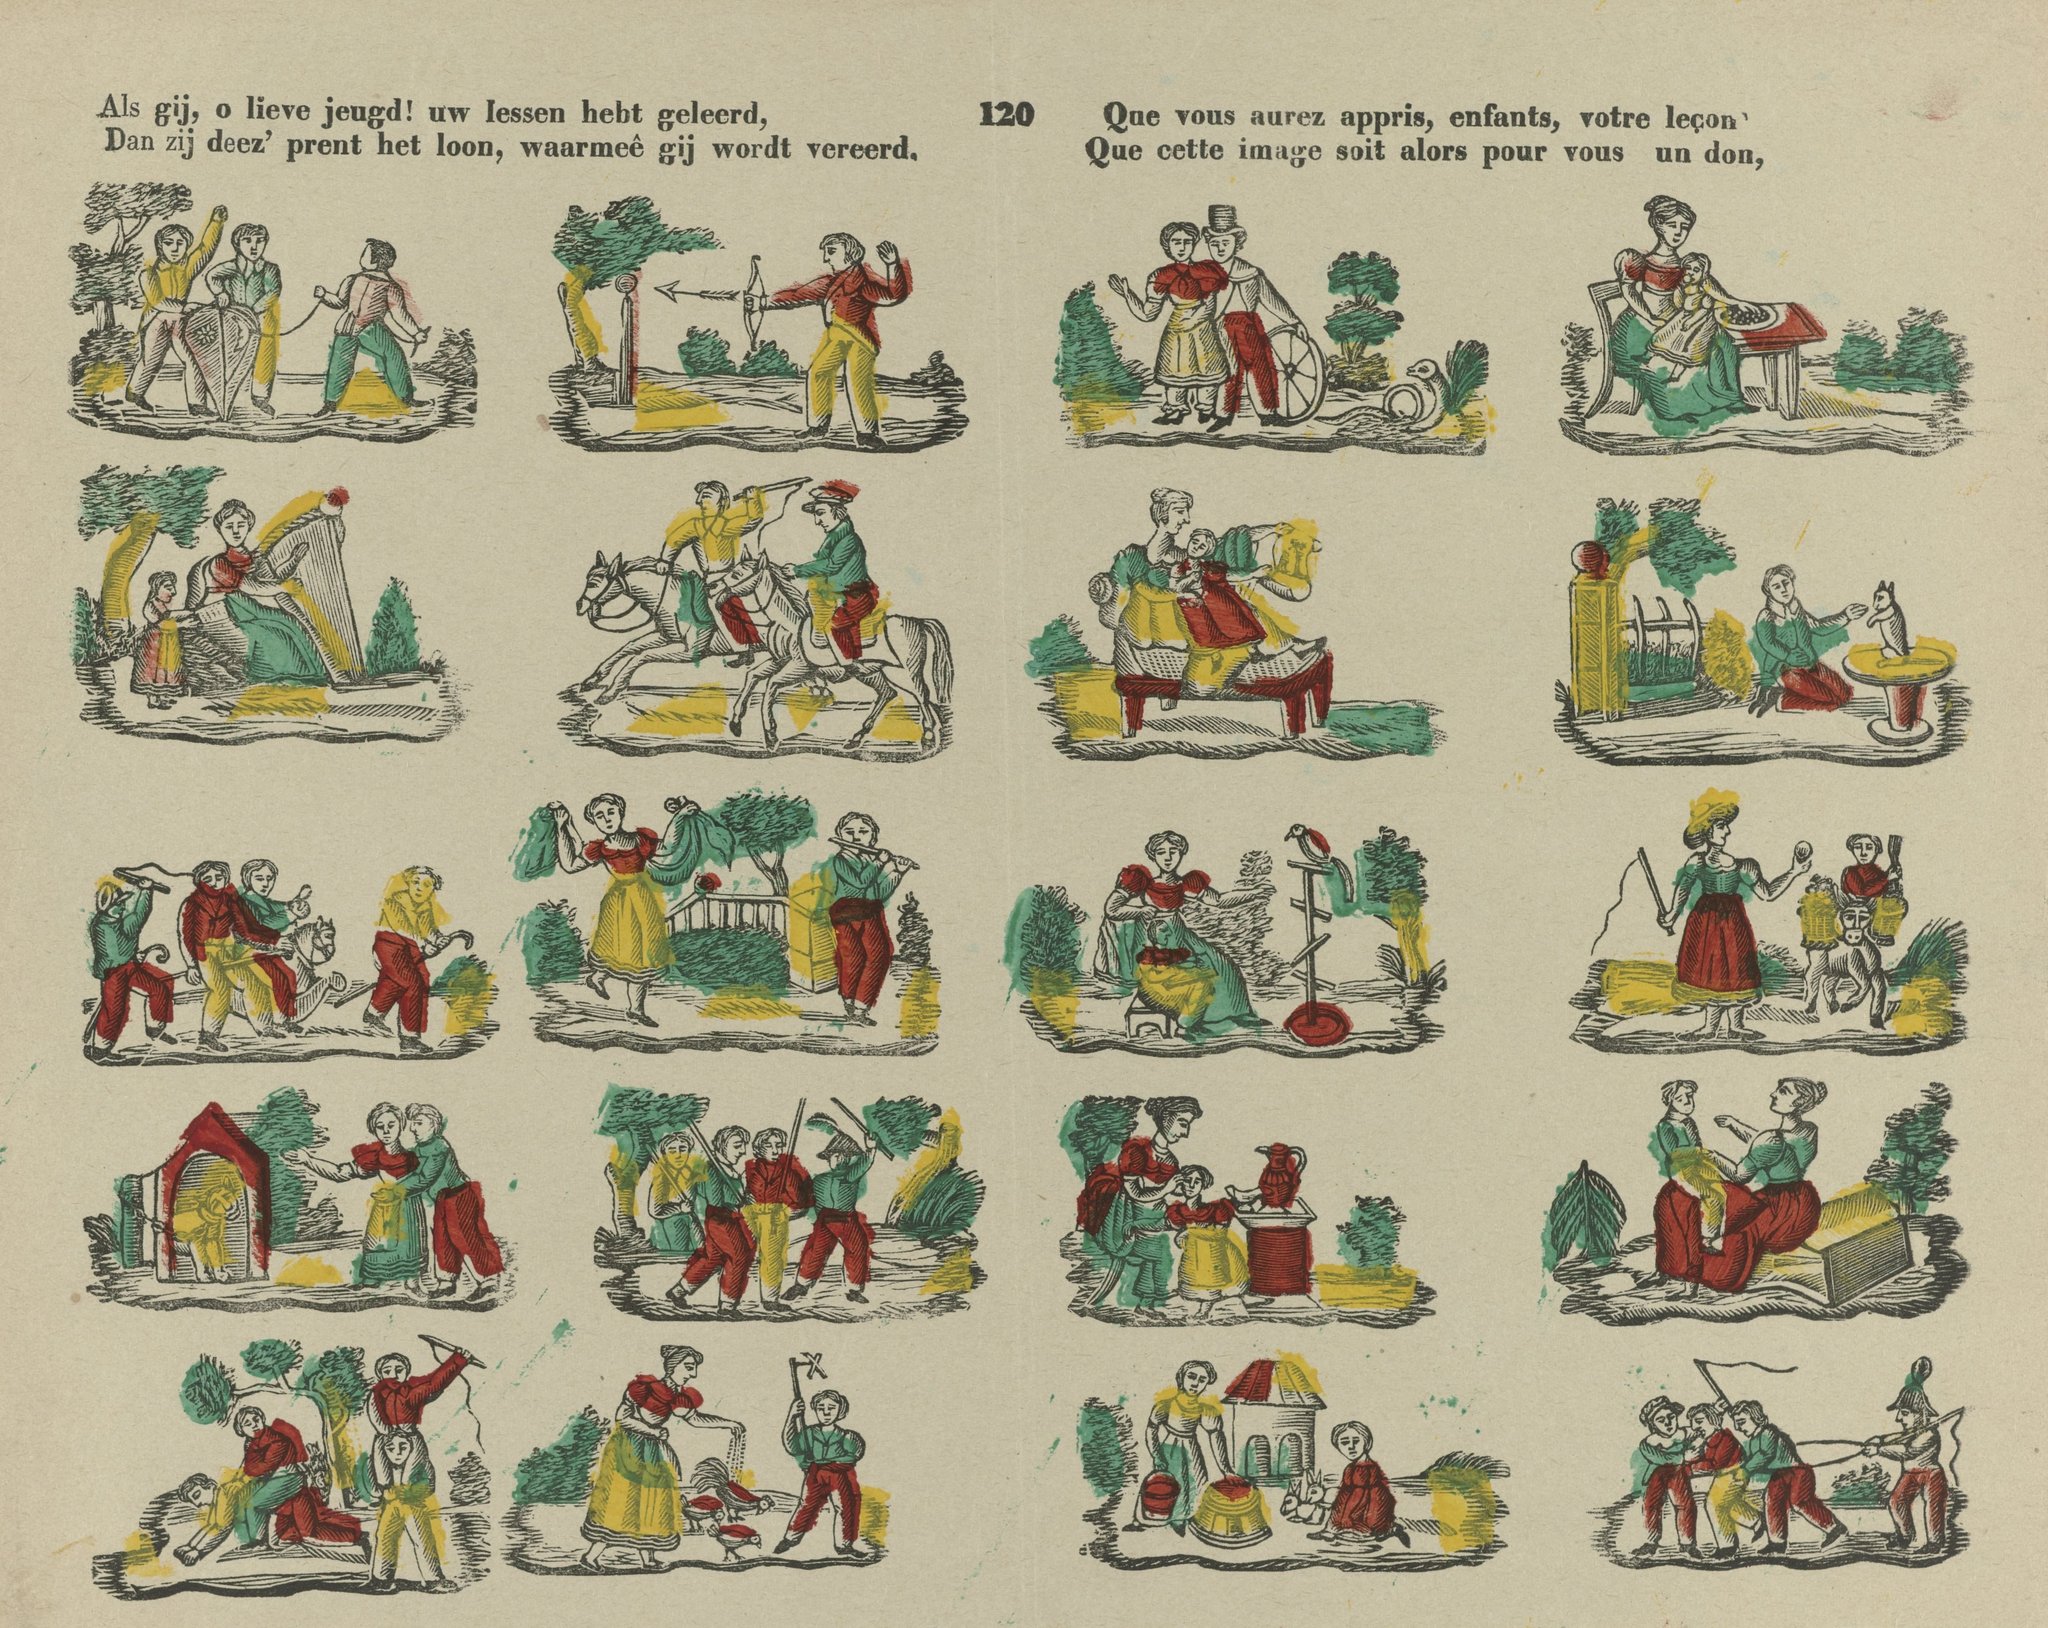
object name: popular print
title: Als gij, o lieve jeugd! uw lessen hebt geleerd, / Dan zij deez' prent het loon, waarmeê gij wordt vereerd / Que vous aurez appris, enfants, votre leçon / Que cette image soit alors pour vous un don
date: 1800-1833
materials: paper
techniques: colour, letterpress printing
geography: turnhout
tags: children's games and plays, making music; musician with instrument, feeding wild animals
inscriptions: collector's mark: Lugt 2760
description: Blad met 20 voorstellingen van verschillende kinderspelen en bezigheden, waaronder harp spelen, paardrijden en de kippen voeren. Genummerd midden boven: 120.